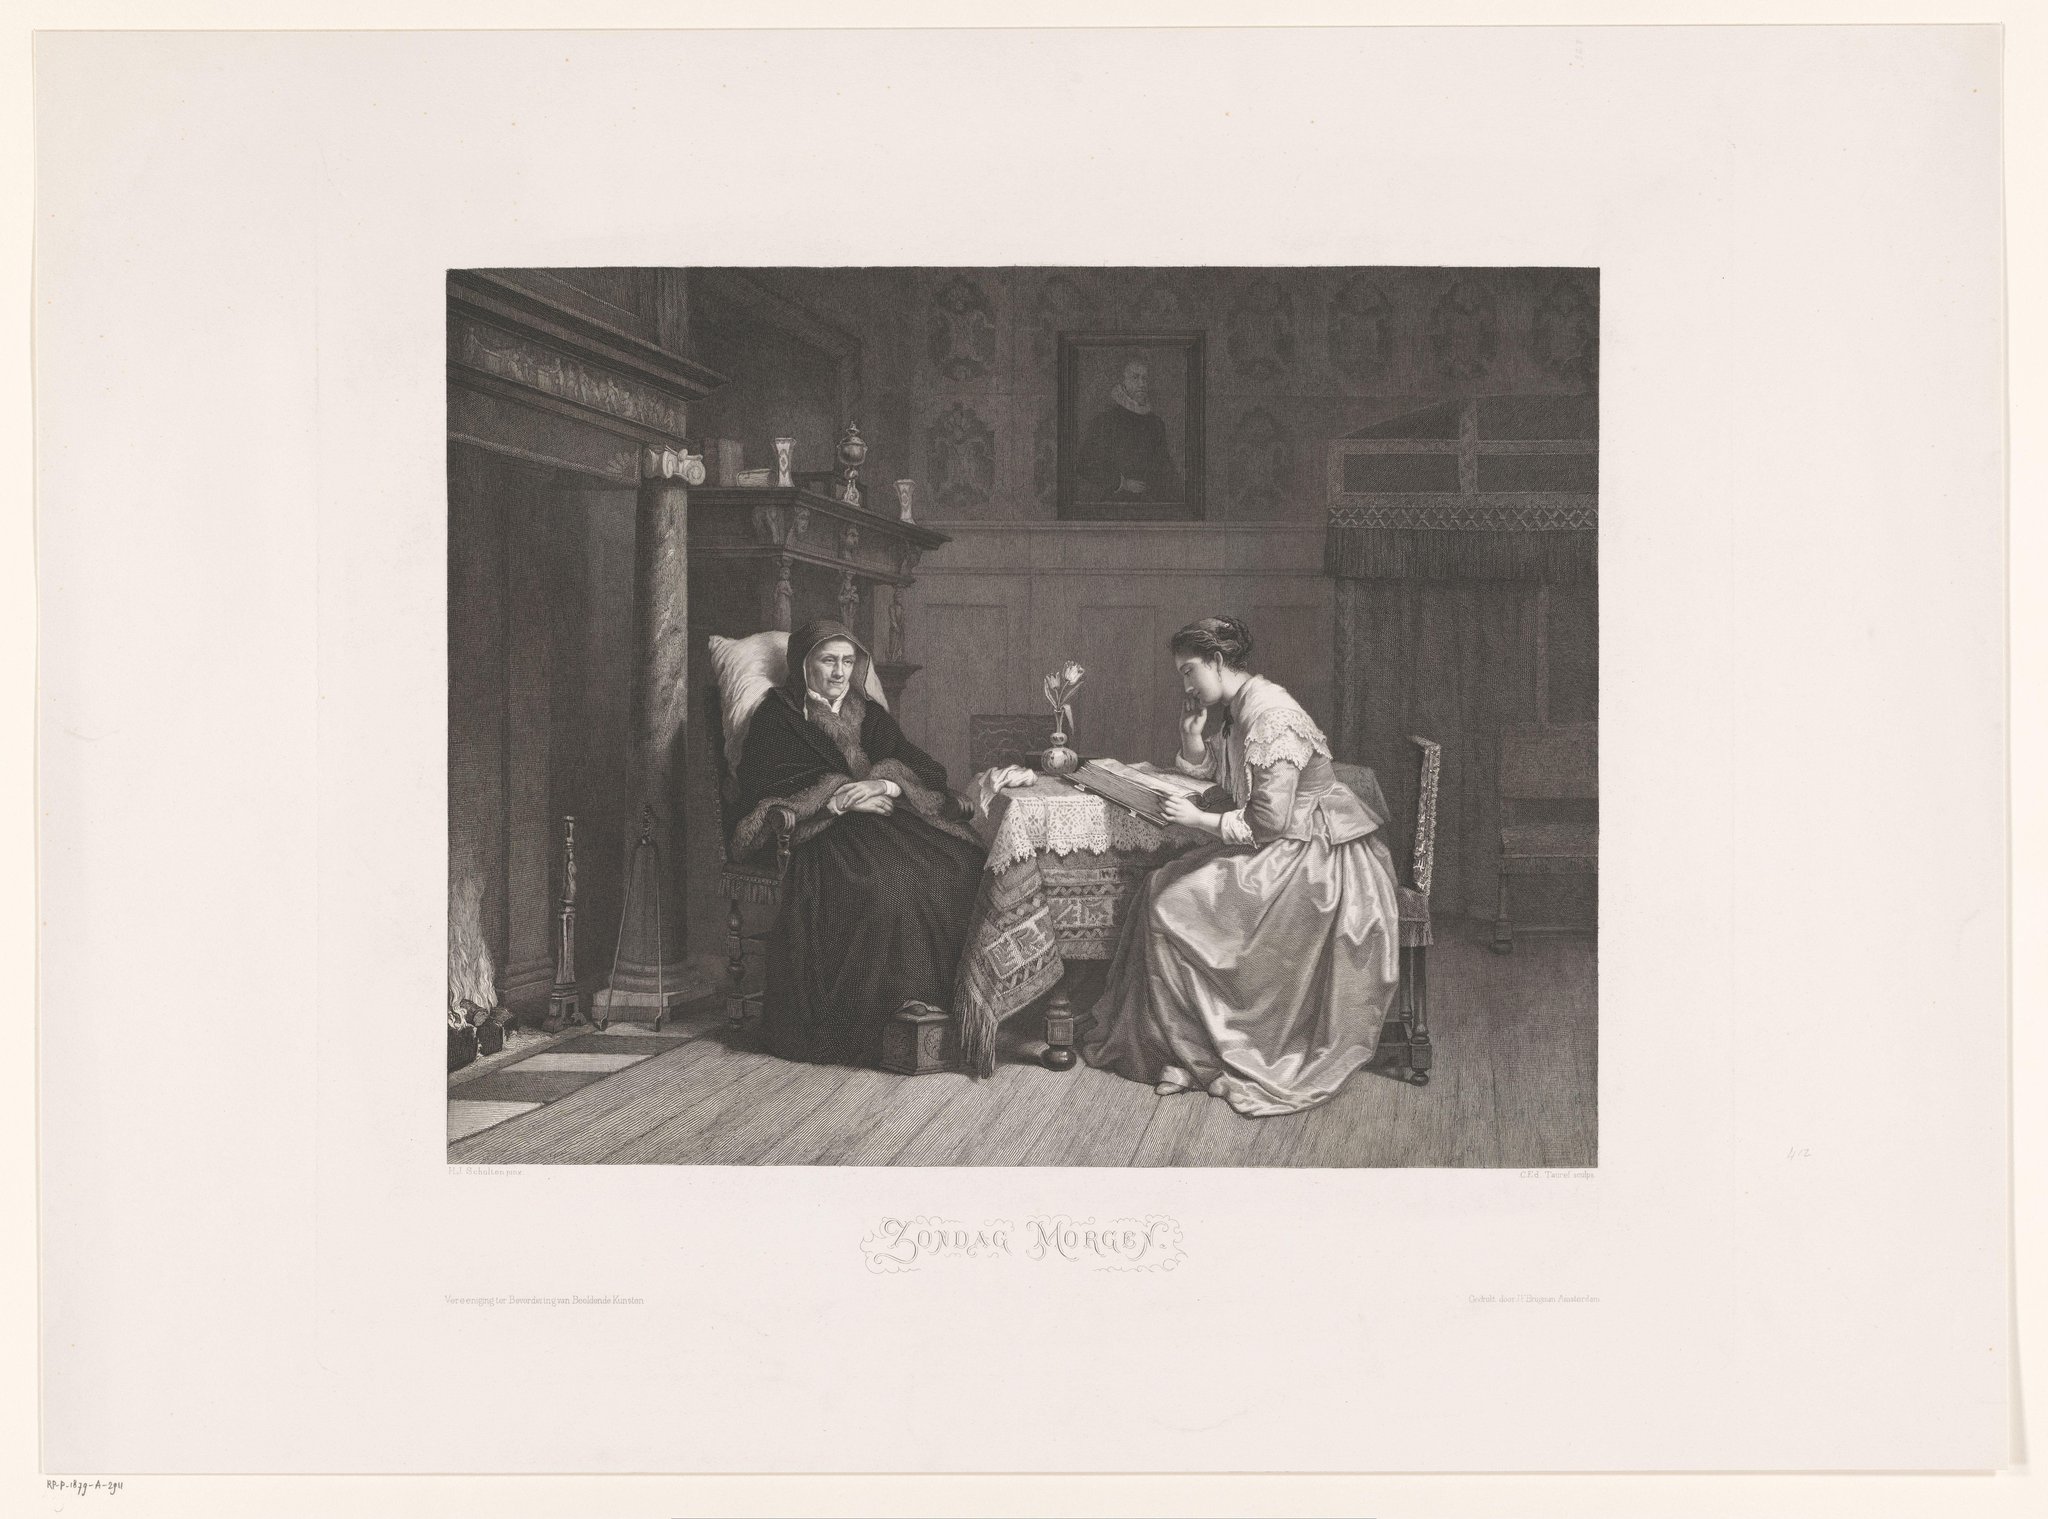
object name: print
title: Zondag Morgen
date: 1834-1879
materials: paper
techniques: engraving, etching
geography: amsterdam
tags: foot-stove, open hearth, fire-place, interior of the house, reading to somebody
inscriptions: collector's mark: Lugt 2228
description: Een jonge dame leest een oude dame voor, die bij een haardvuur in een leunstoel zit. De voet van de oude vrouw rust op een voetstoof.